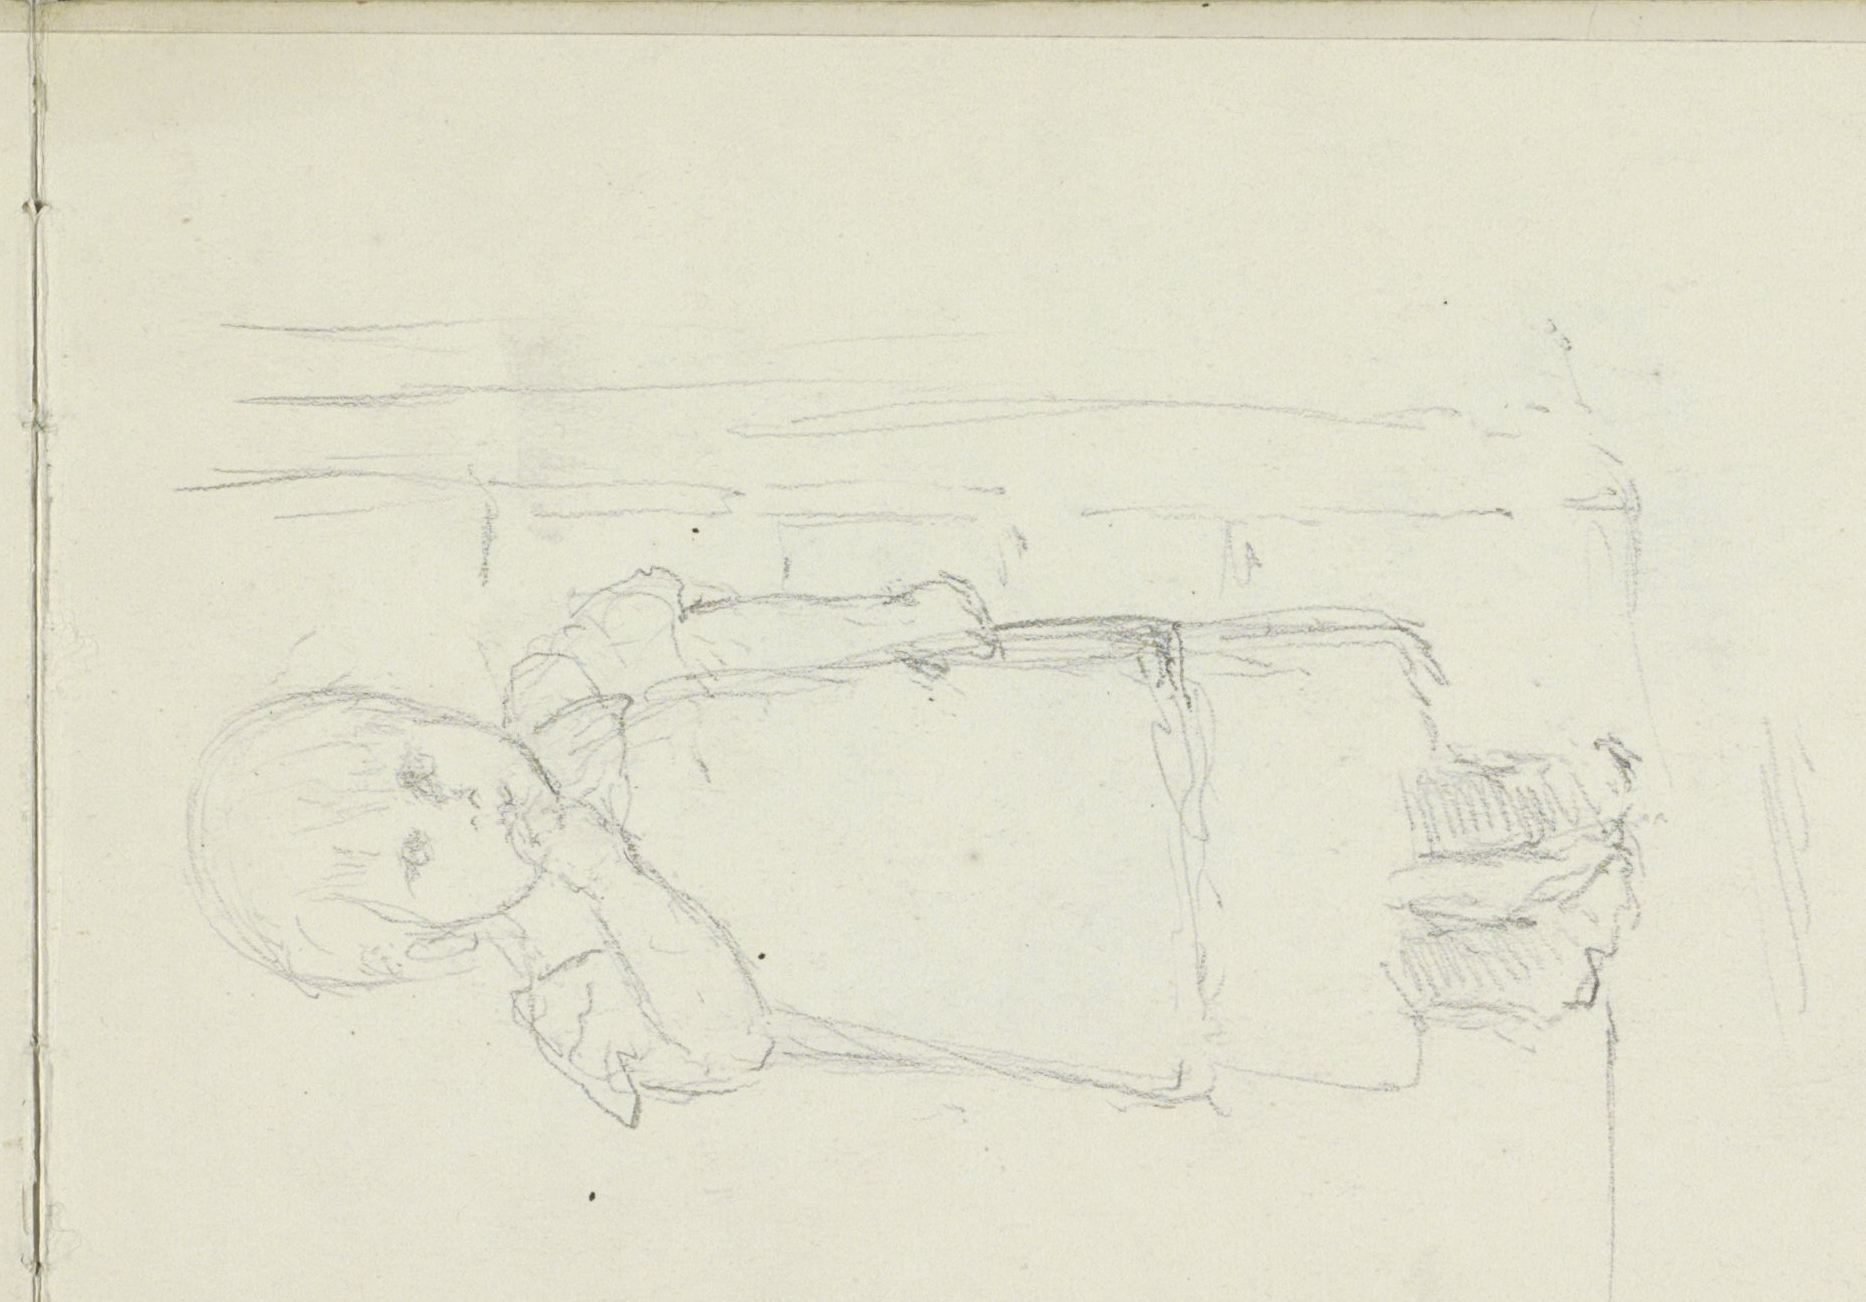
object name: sketchbook leaf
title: Staand kind in een deuropening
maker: jozef israëls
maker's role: draughtsman, painter, print maker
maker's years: 1824-1911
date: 1885-1902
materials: paper, pencil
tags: hand(s) towards the mouth, child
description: Het kind reikt met de rechterhand naar de mond. Blad 16 recto uit een schetsboek met 17 bladen.